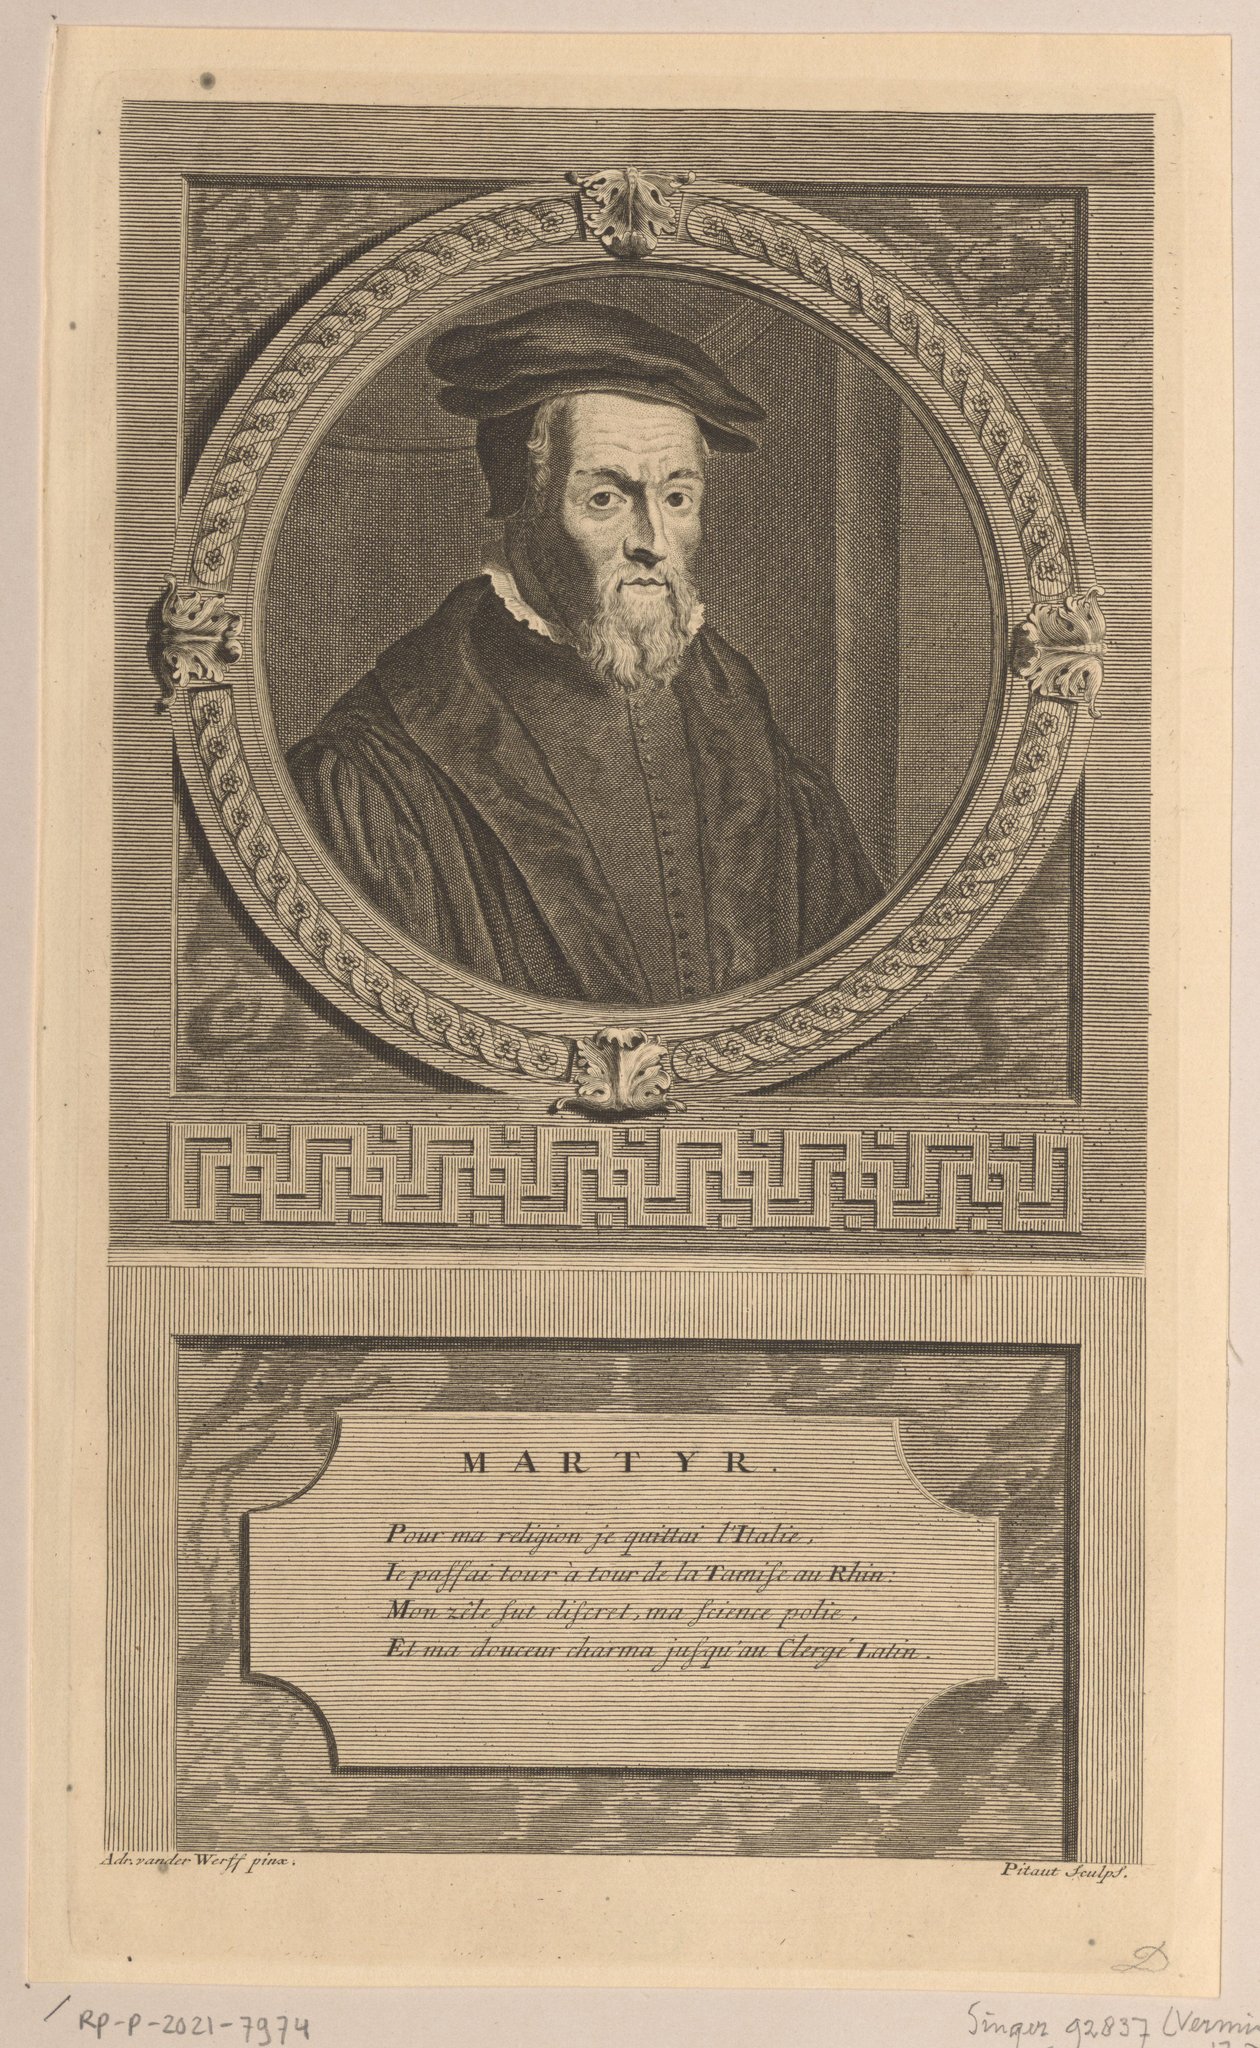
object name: book illustration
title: Portret van Petrus Martyr Vermigli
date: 1697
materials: paper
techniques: engraving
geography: paris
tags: reformation (roman catholic church vs. protestantism), theologian, ornament ~ medallion, historical persons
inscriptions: collector's mark: Lugt 2228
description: Prent waarschijnlijk uit: Larrey, Isaac de. Histoire d'Angleterre, d'Ecosse, et d'Irlande (...). Rotterdam: Reinier Leers, 1697, dl. 1.